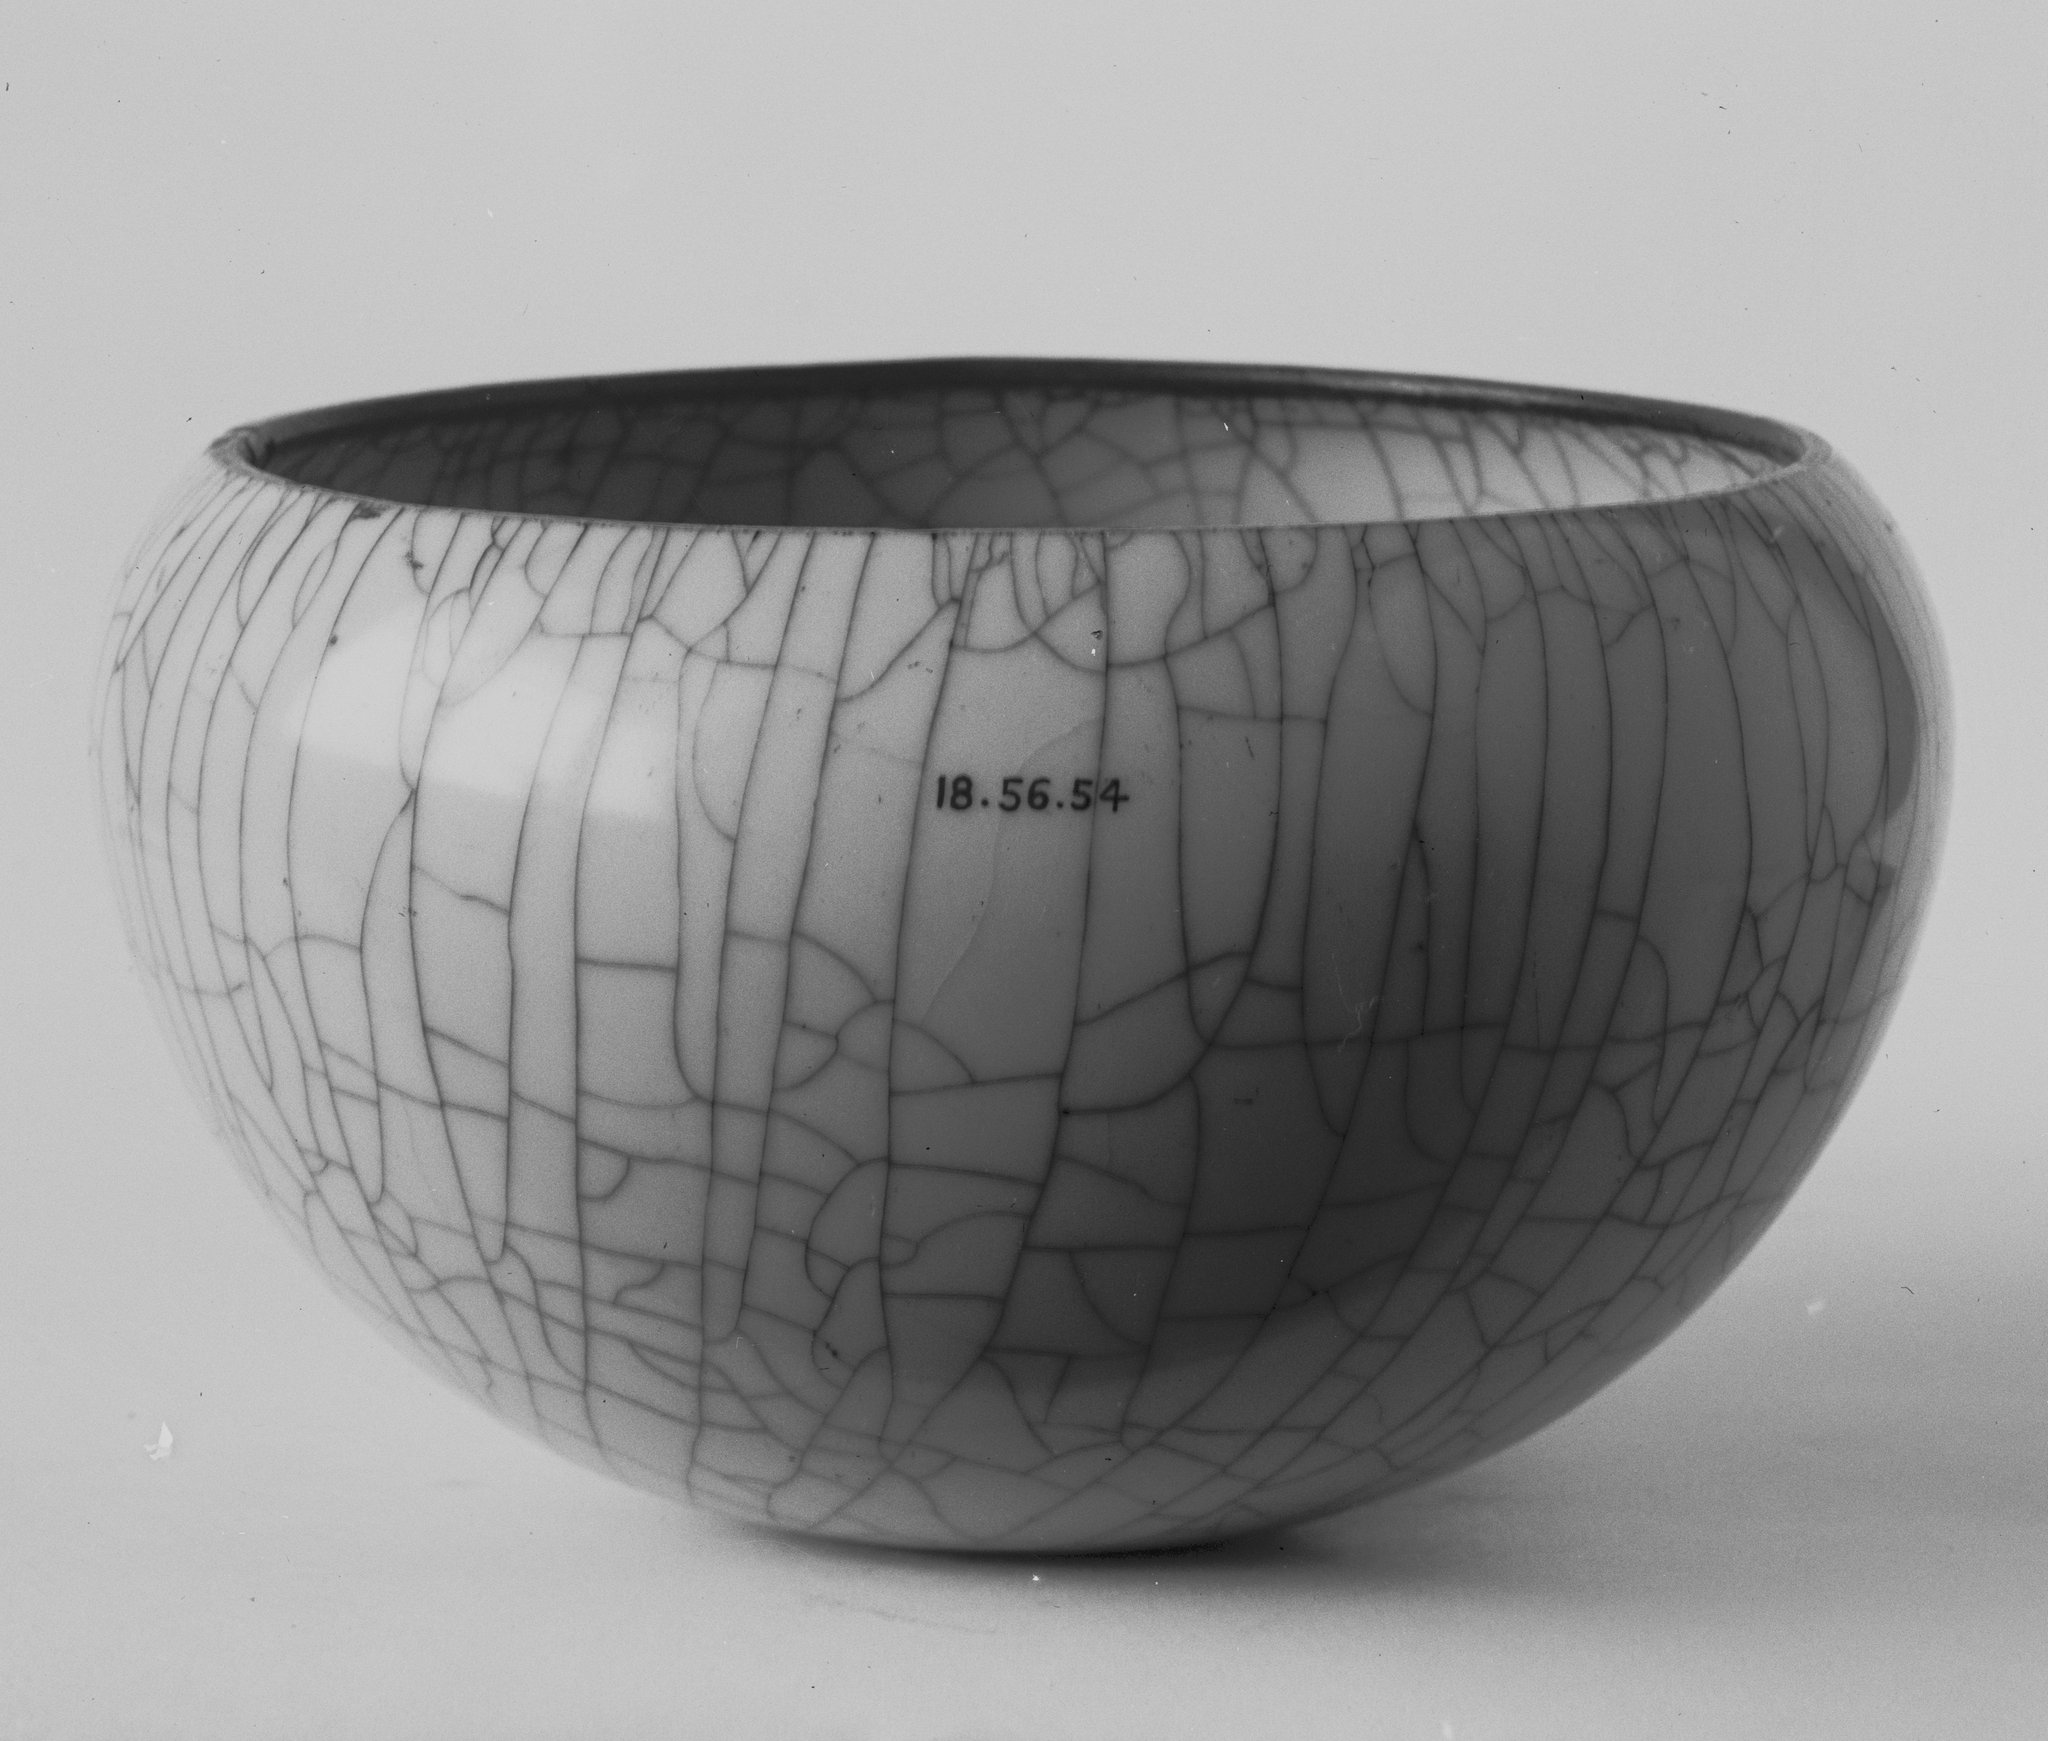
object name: bowl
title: Begging Bowl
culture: chinese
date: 960-1127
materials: pottery